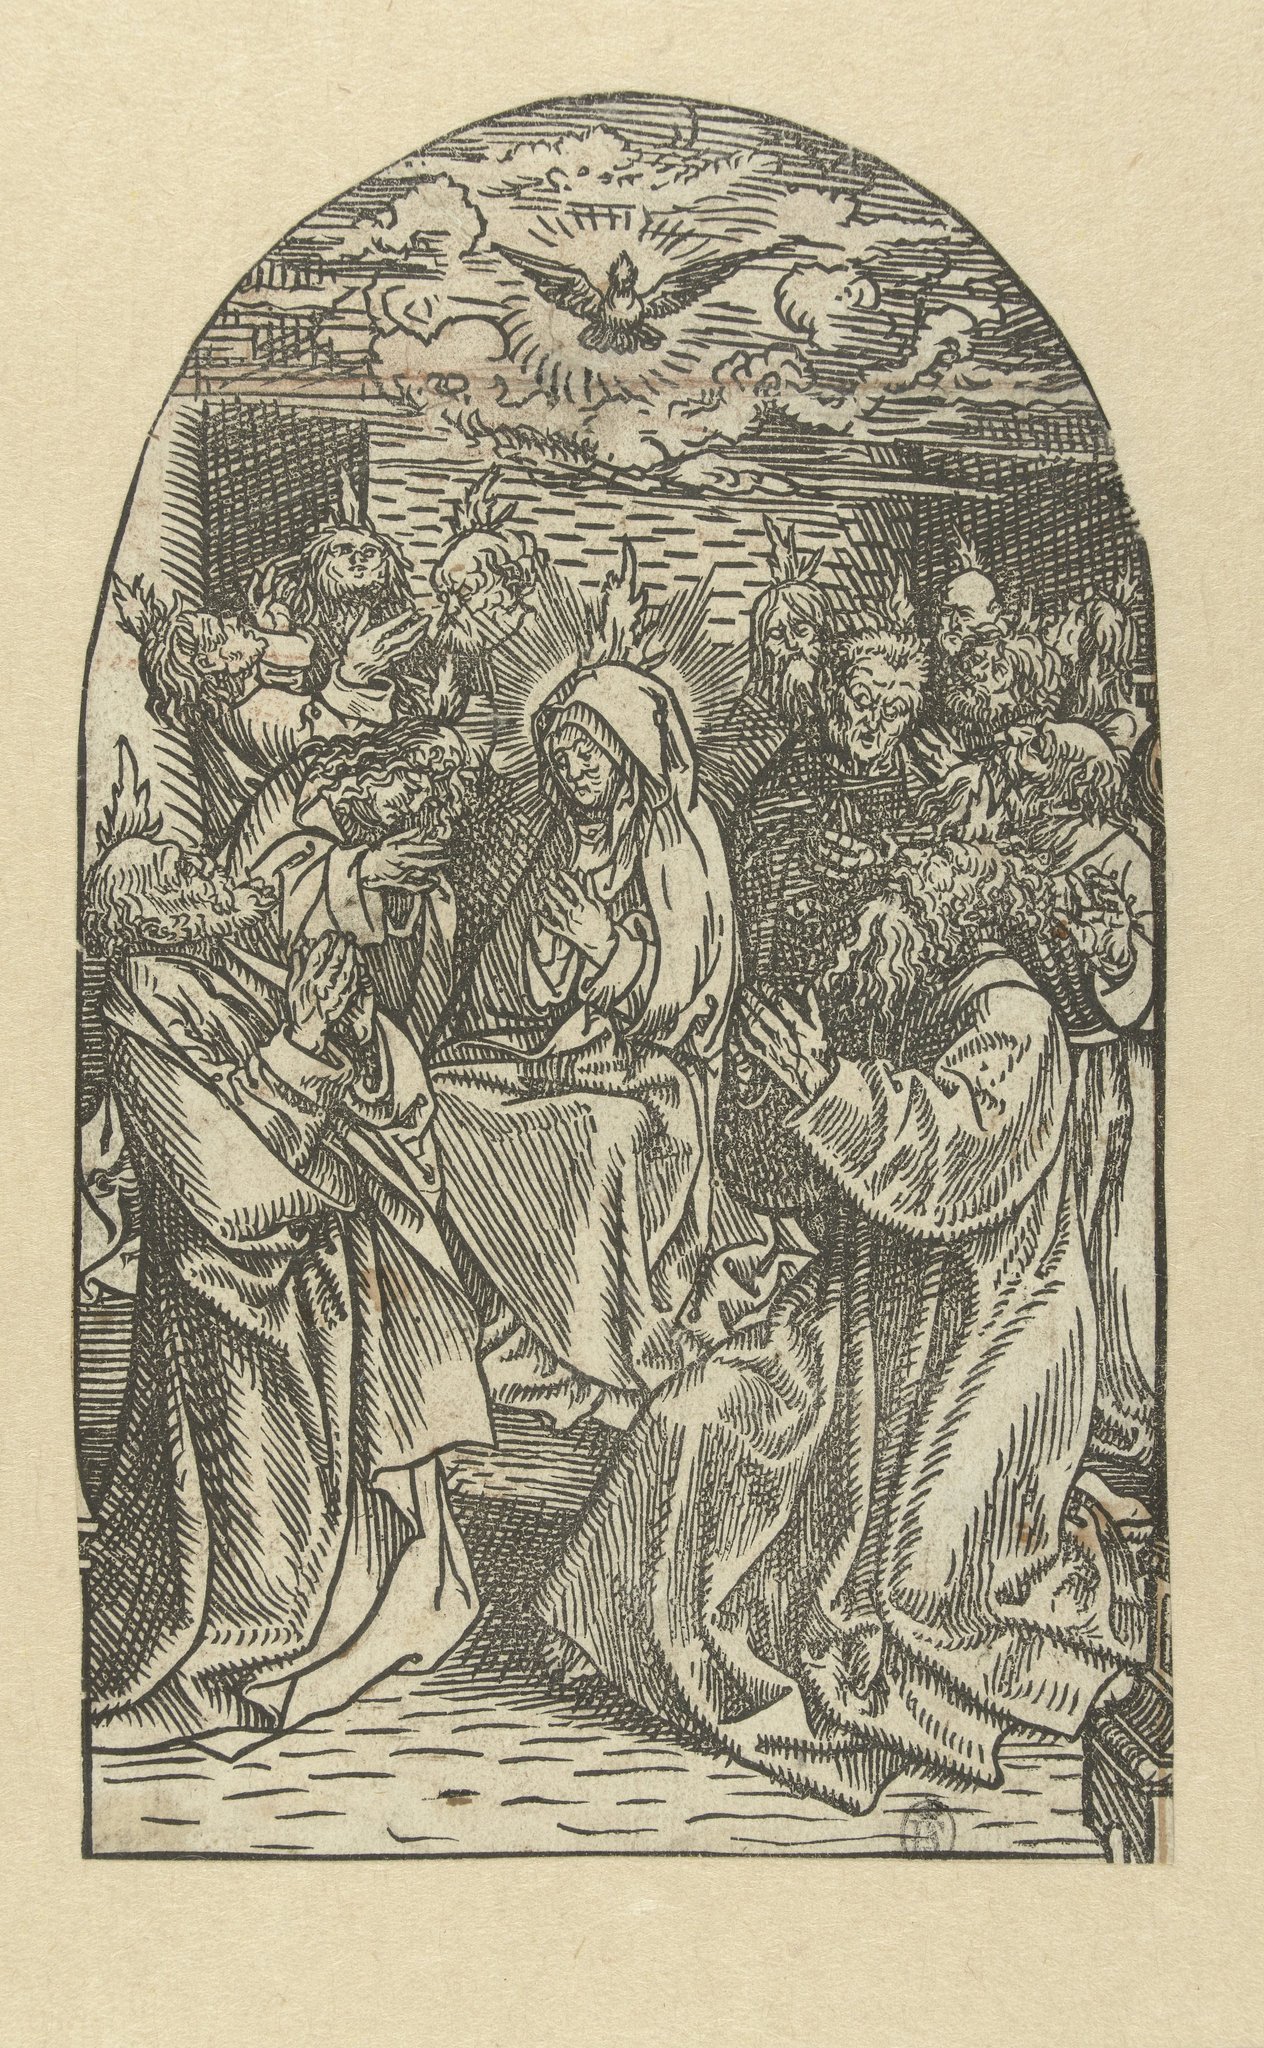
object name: print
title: Het Leven van Maria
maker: jacob cornelisz van oostsanen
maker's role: draughtsman, painter, print maker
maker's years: 1475-1533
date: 1507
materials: paper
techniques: woodcut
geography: low countries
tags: pentecost: the holy ghost descends upon (mary and) the apostles, sometimes paul and/or representatives of the nations present (acts 2:1-4)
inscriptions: collector's mark: Lugt 971, collector's mark: Lugt 2228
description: Fragment van een prent met vier voorstellingen, uit een serie van zeven. Maria omringd door twaalf apostelen met vlam boven hoofd. Heilige Geest in wolk boven hen.